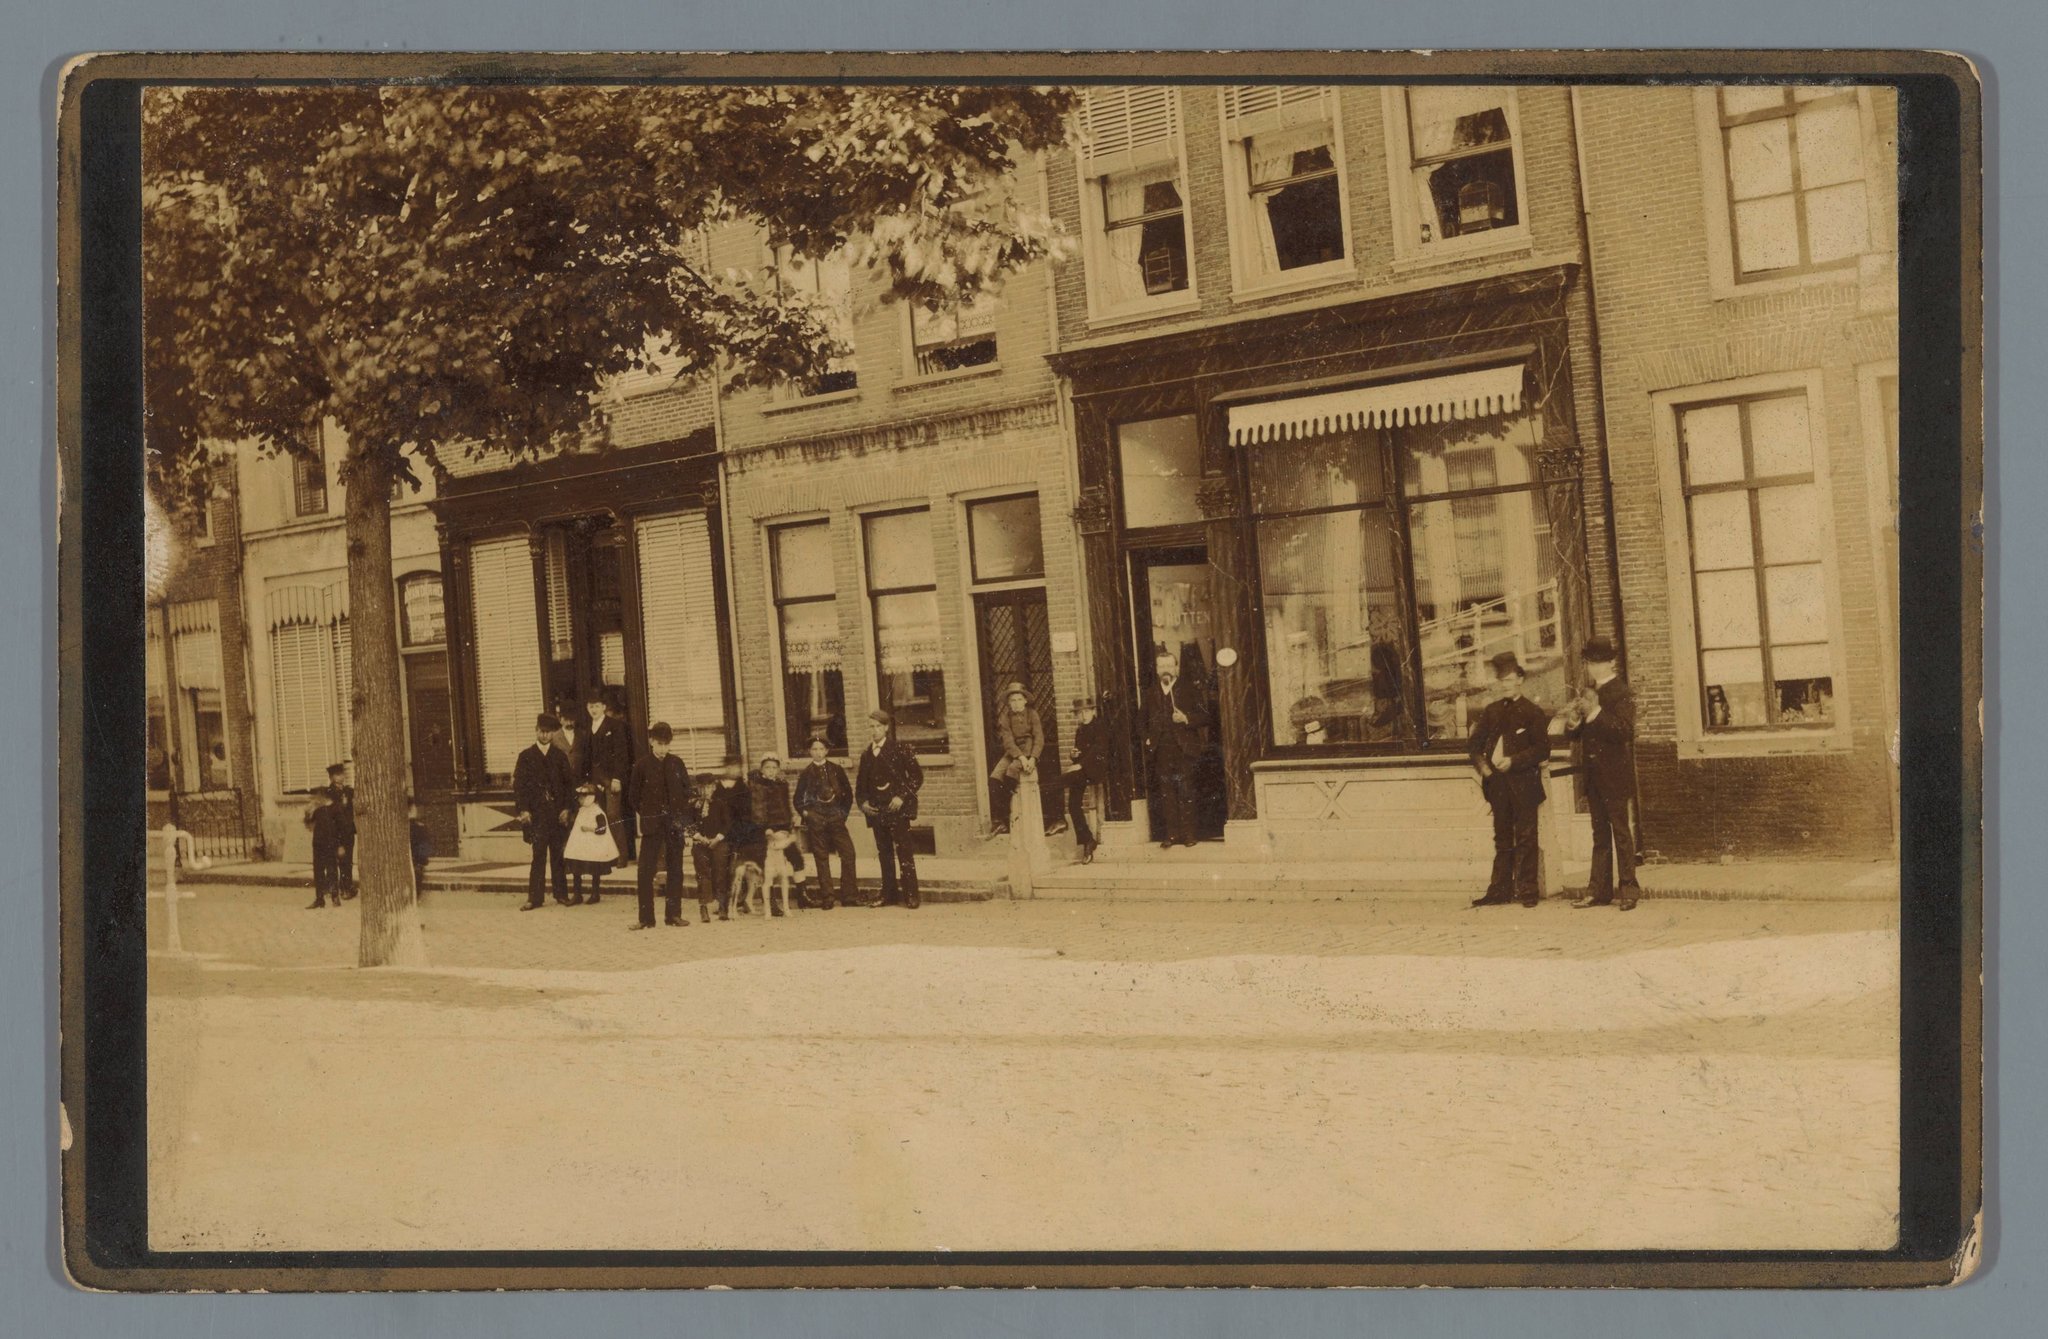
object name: cabinet photograph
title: Gezicht op een straat met een groep mensen te Schoonhoven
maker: Anonymous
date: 1850-1900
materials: paper, cardboard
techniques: gelatin silver print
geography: schoonhoven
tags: schoonhoven